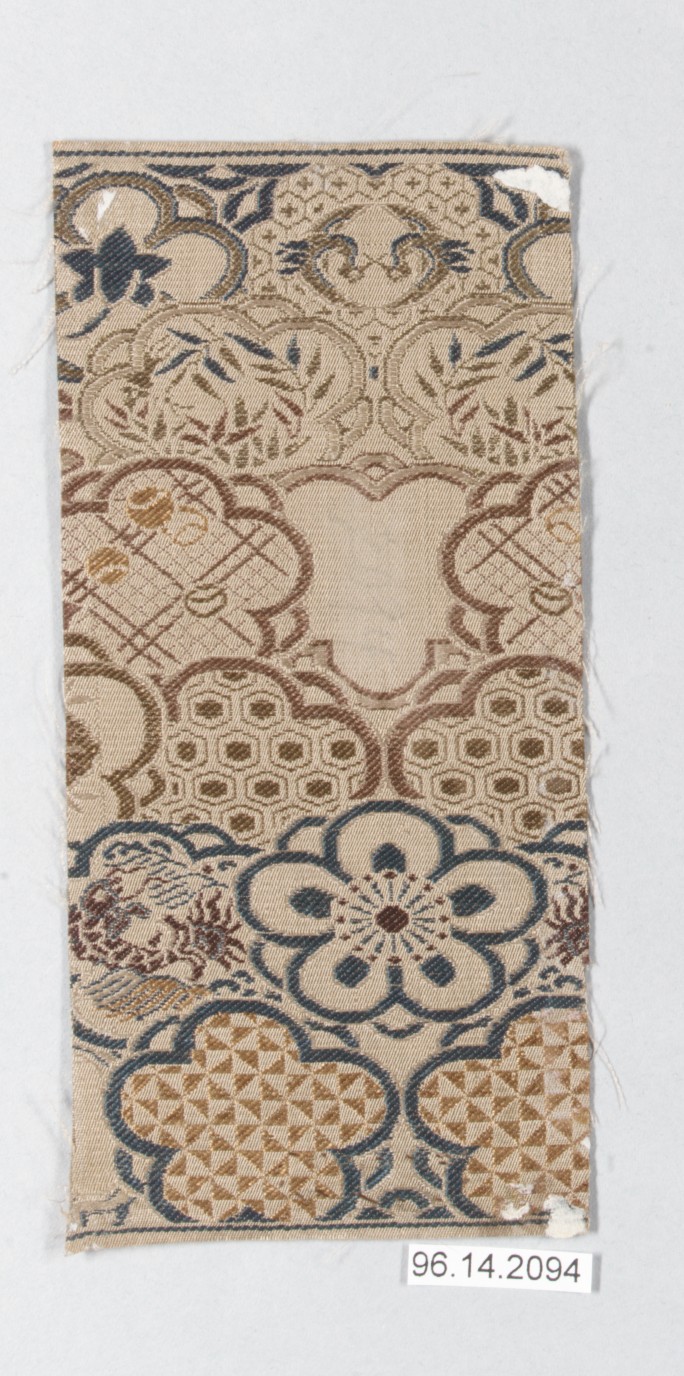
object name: piece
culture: japanese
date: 1701-1900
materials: silk